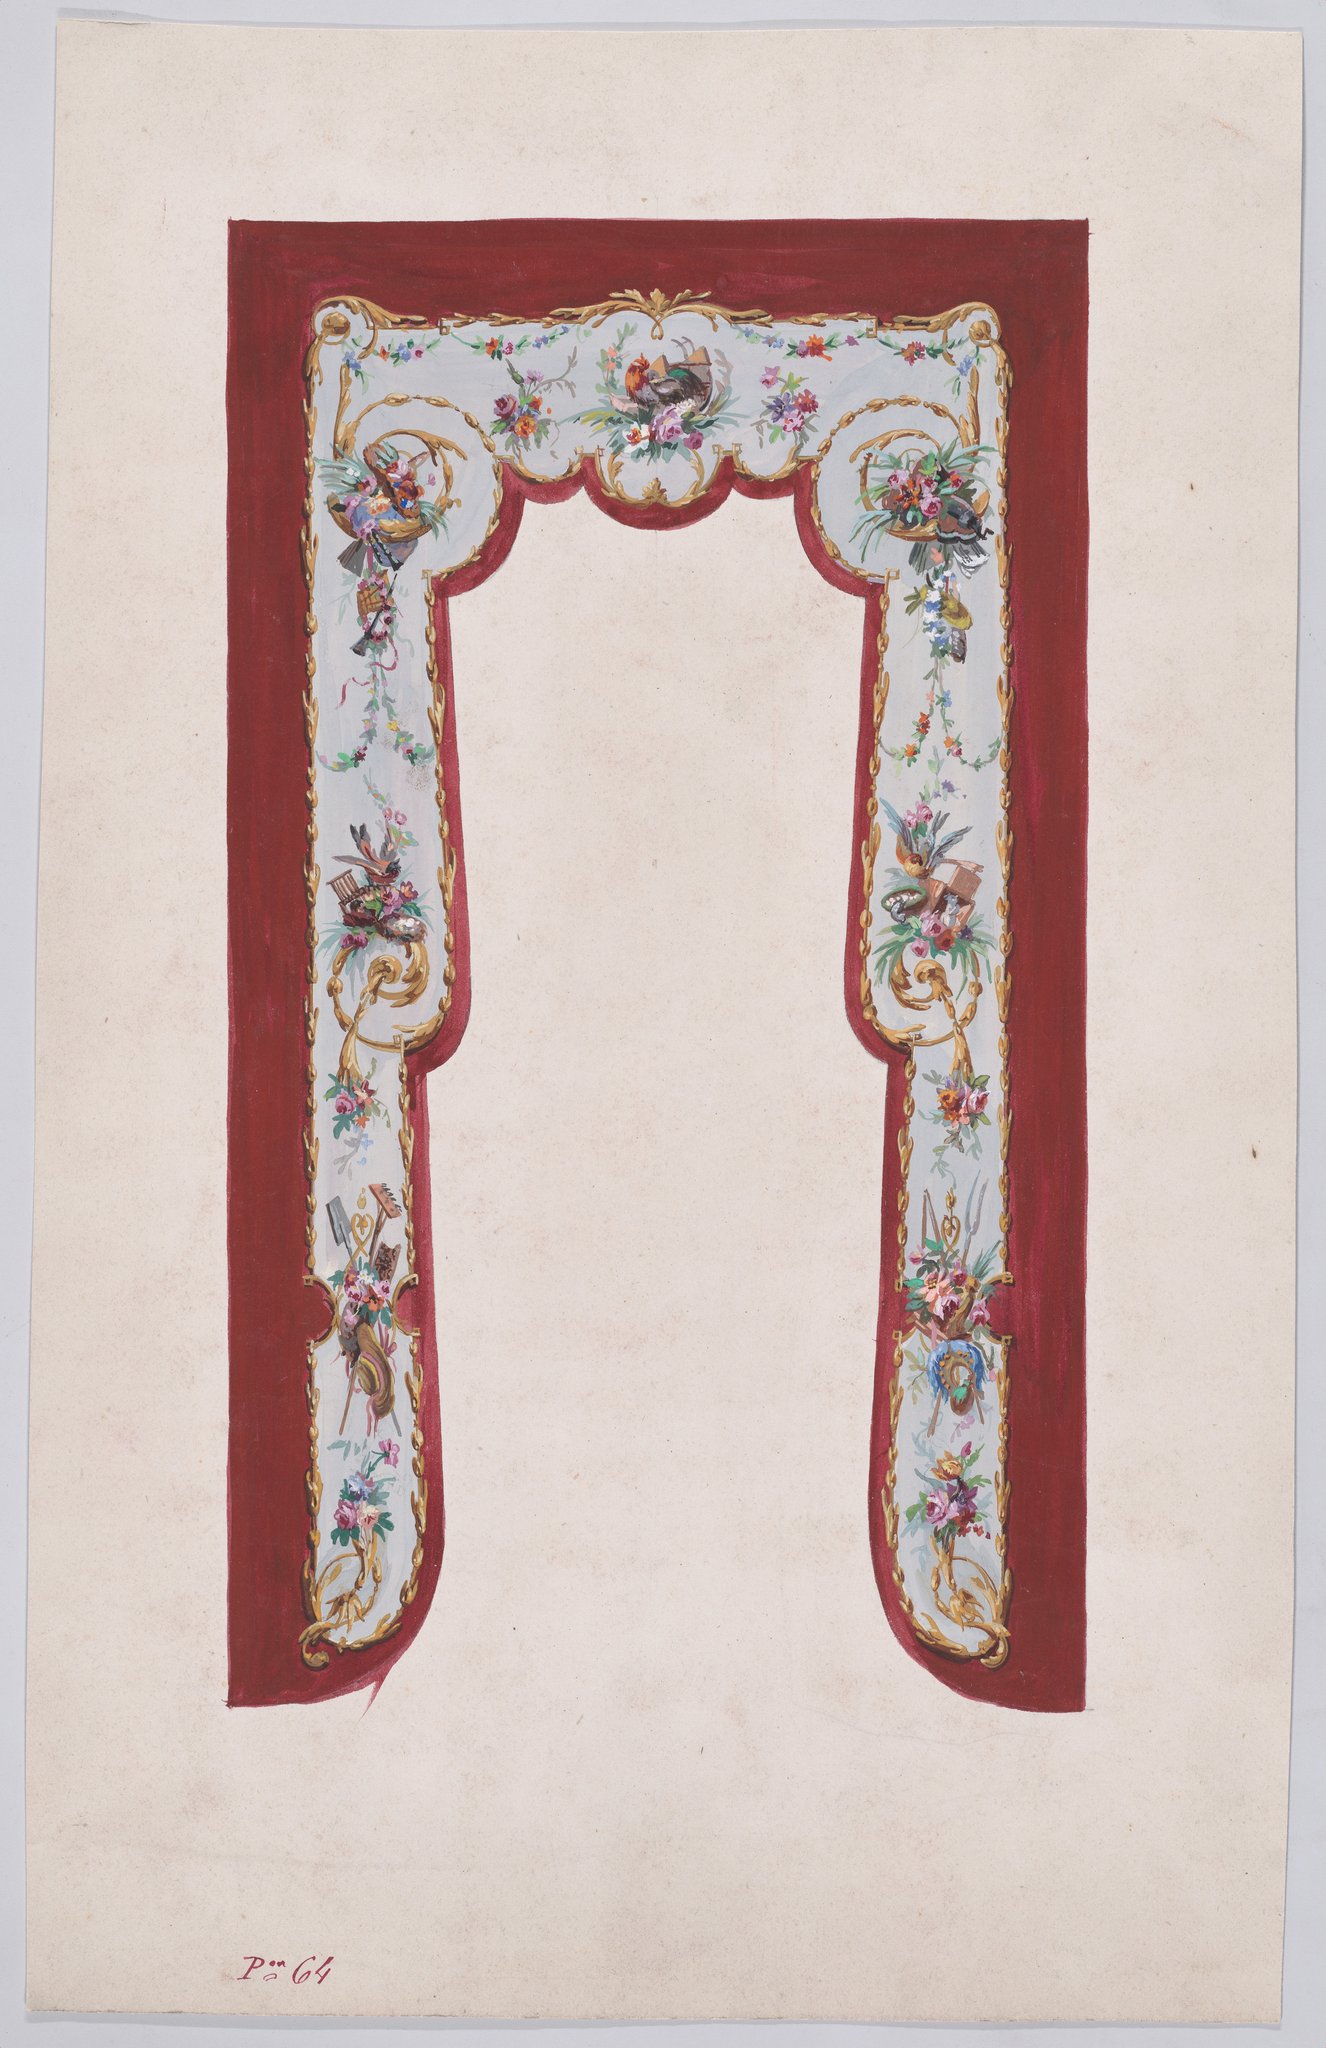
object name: drawing ornament architecture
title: Design for a Valance with Bundles and Garlands of Flowers and Leaves Decorated with Gardening Tools upon which Small Birds Rest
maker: anonymous, french, 19th century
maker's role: designer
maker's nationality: french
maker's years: 1800-1900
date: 1870-1900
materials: watercolor